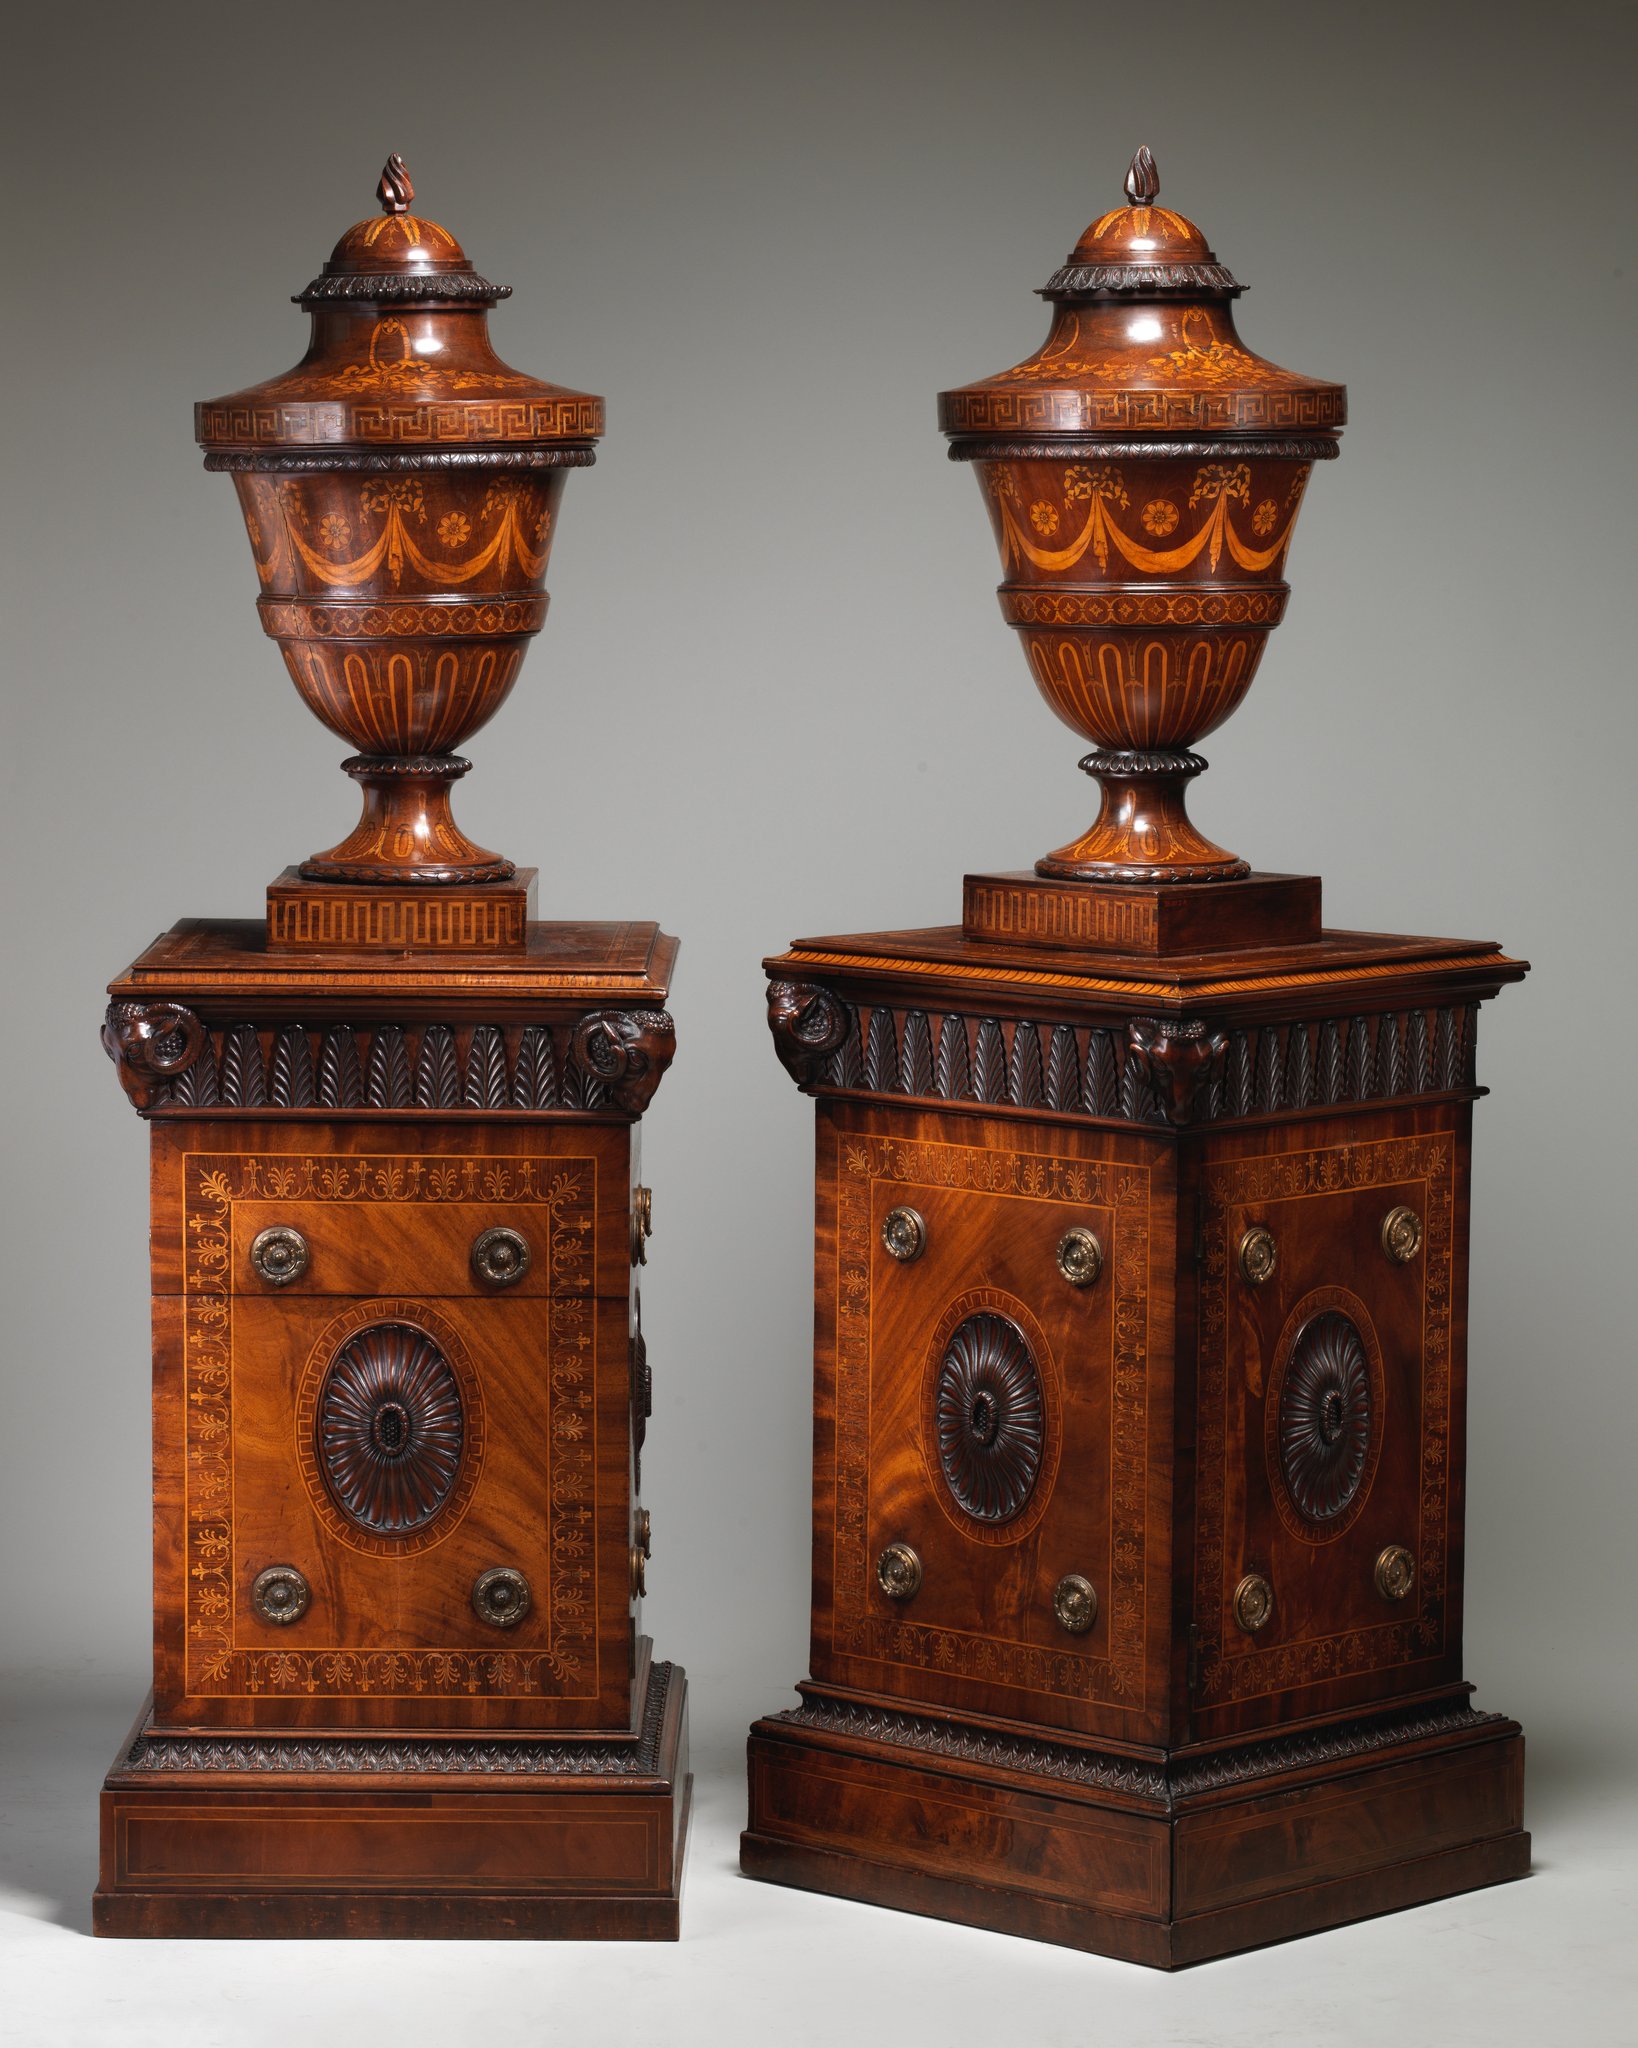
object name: urn and pedestal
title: Pair of urns and pedestals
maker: robert adam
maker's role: designer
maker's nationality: british, scottish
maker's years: 1728-1792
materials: wood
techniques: inlay